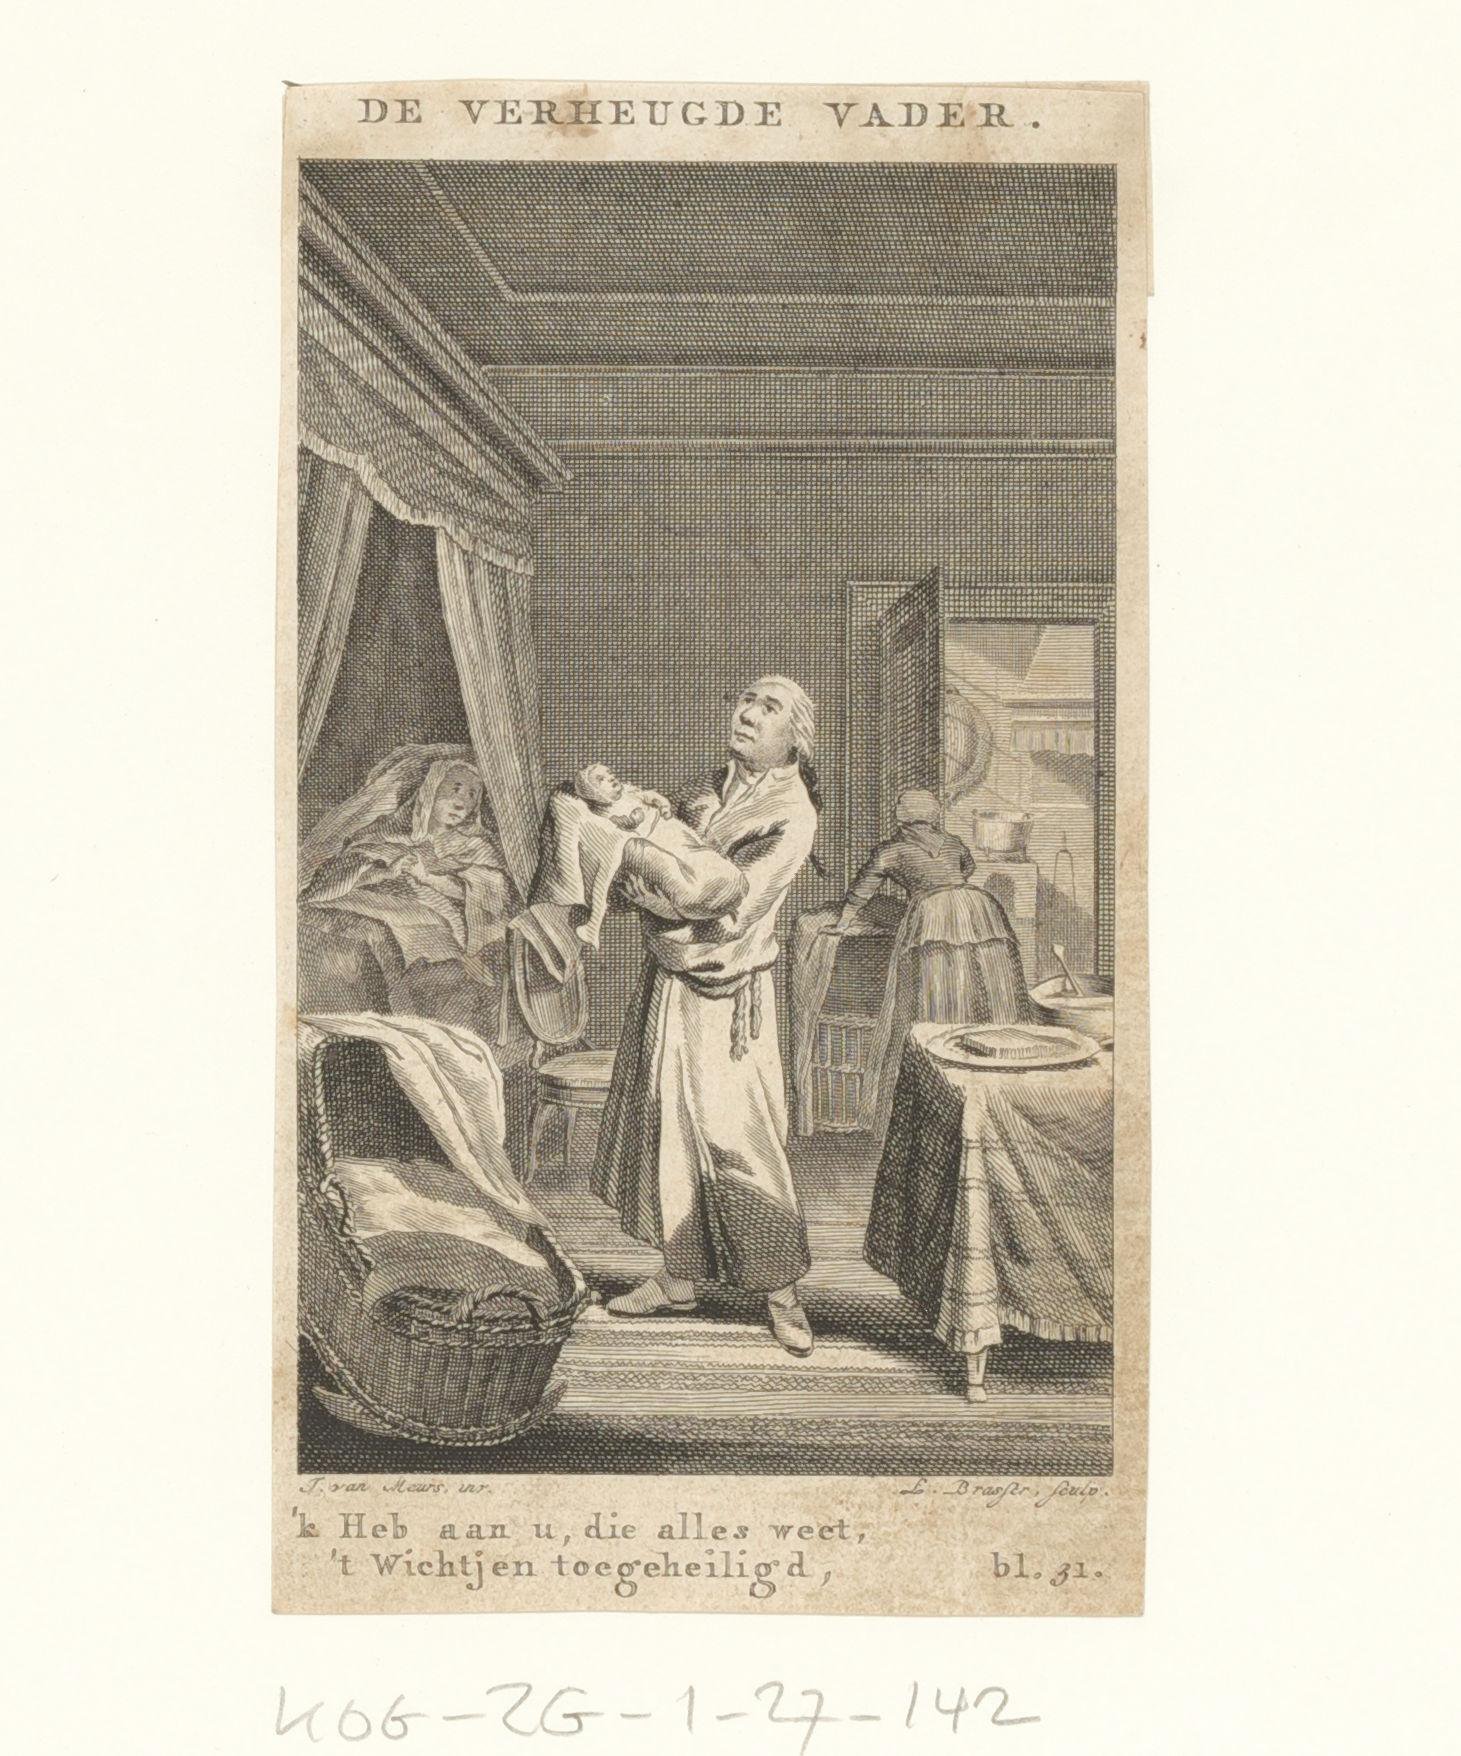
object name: book illustration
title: De verheugde vader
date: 1789-1791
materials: paper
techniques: engraving, etching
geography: netherlands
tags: the new-born child shown to the father, family life at home, bedroom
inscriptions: collector's mark, collector's mark: Lugt 1641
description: Gebruikt als illustratie in: Volks-liedjes, uitgegeven door de Maatschappij tot Nut van 't Algemeen, Amsterdam: Harmanus Keijzer, Arend Fokke en Cornelis de Vries, 3 delen, 1789-1791, p. 34/35.